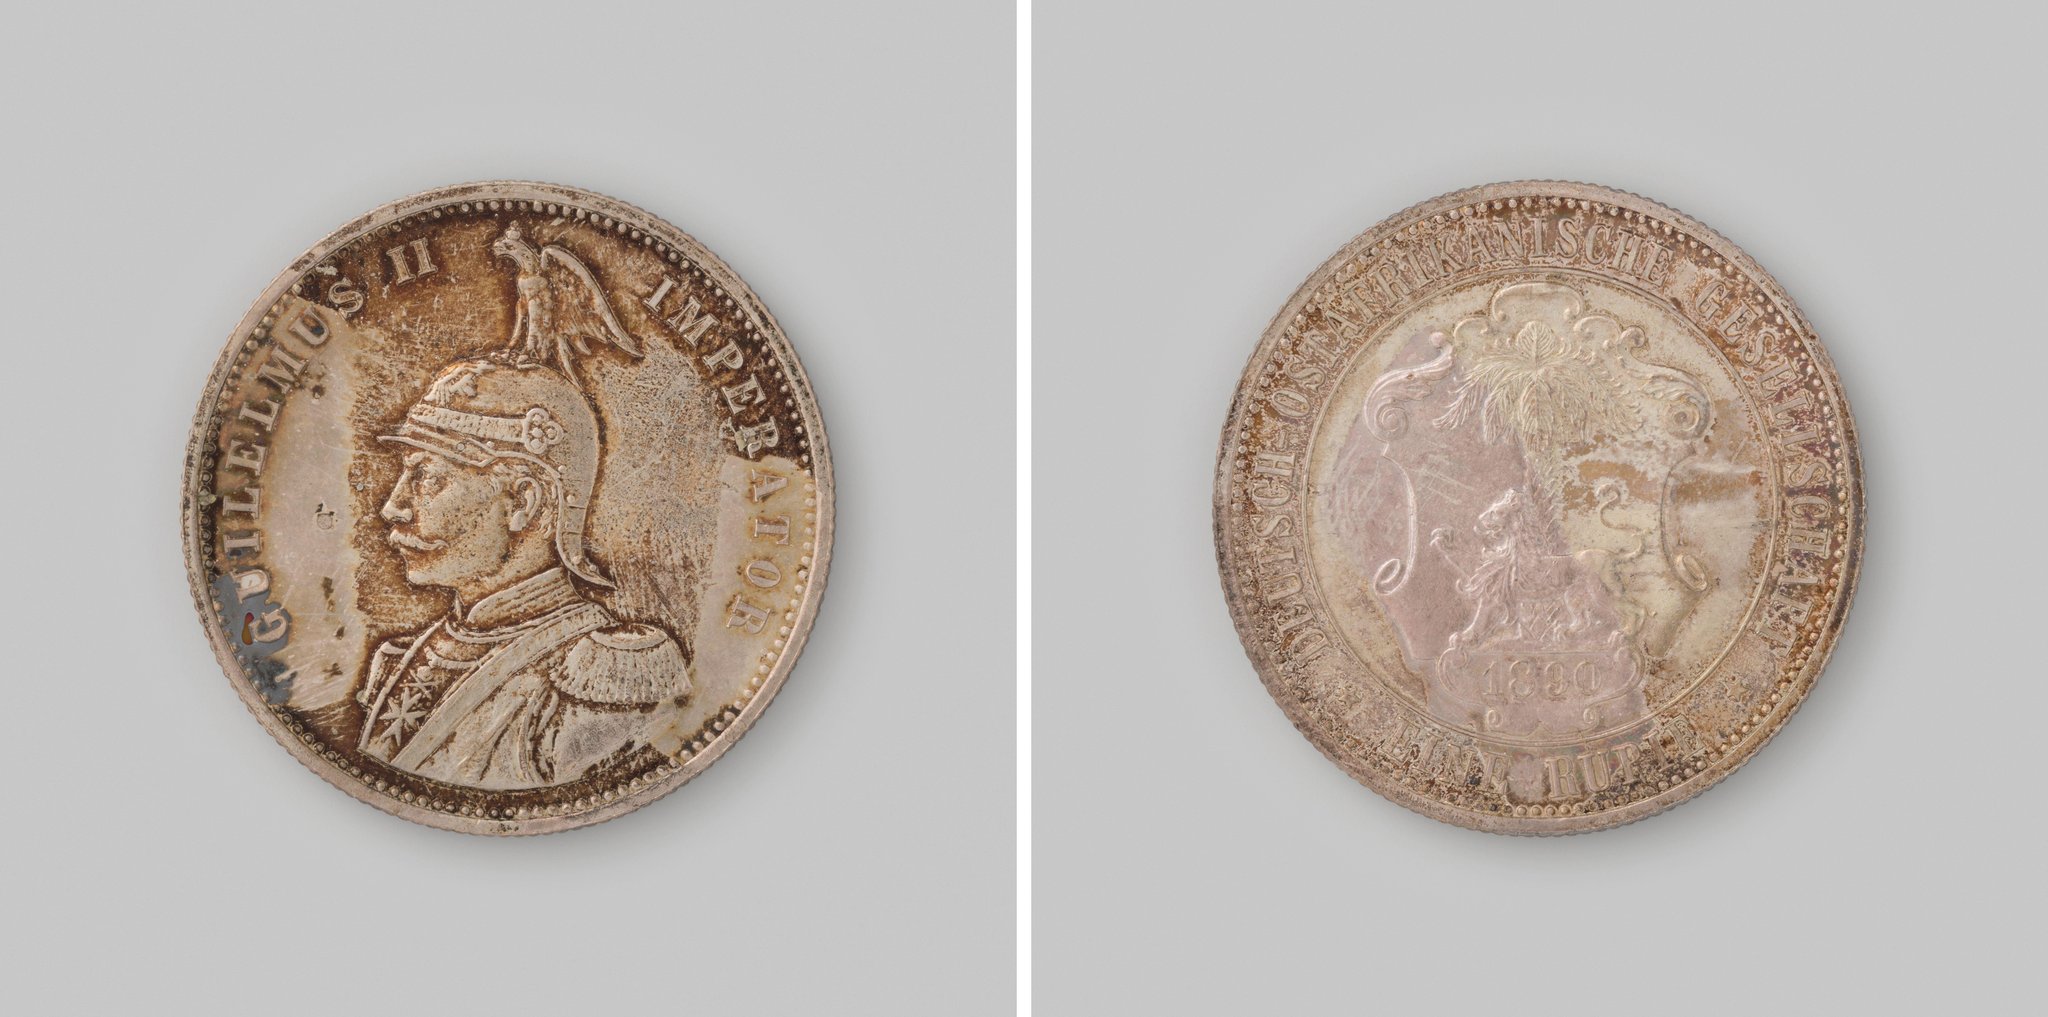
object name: coin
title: Rupie voor Duits Oost Afrika op naam van keizer Wilhelm II, 1890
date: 1890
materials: silver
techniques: striking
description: Zilveren munt. Voorzijde: borstbeeld van keizer Wilhelm naar links met helm, waarop adelaar. Keerzijde: wapenschild van de Deutsch-Ostafikanische Gesellschaft, met in afsnede jaartal. Waarde-aanduiding onderaan.